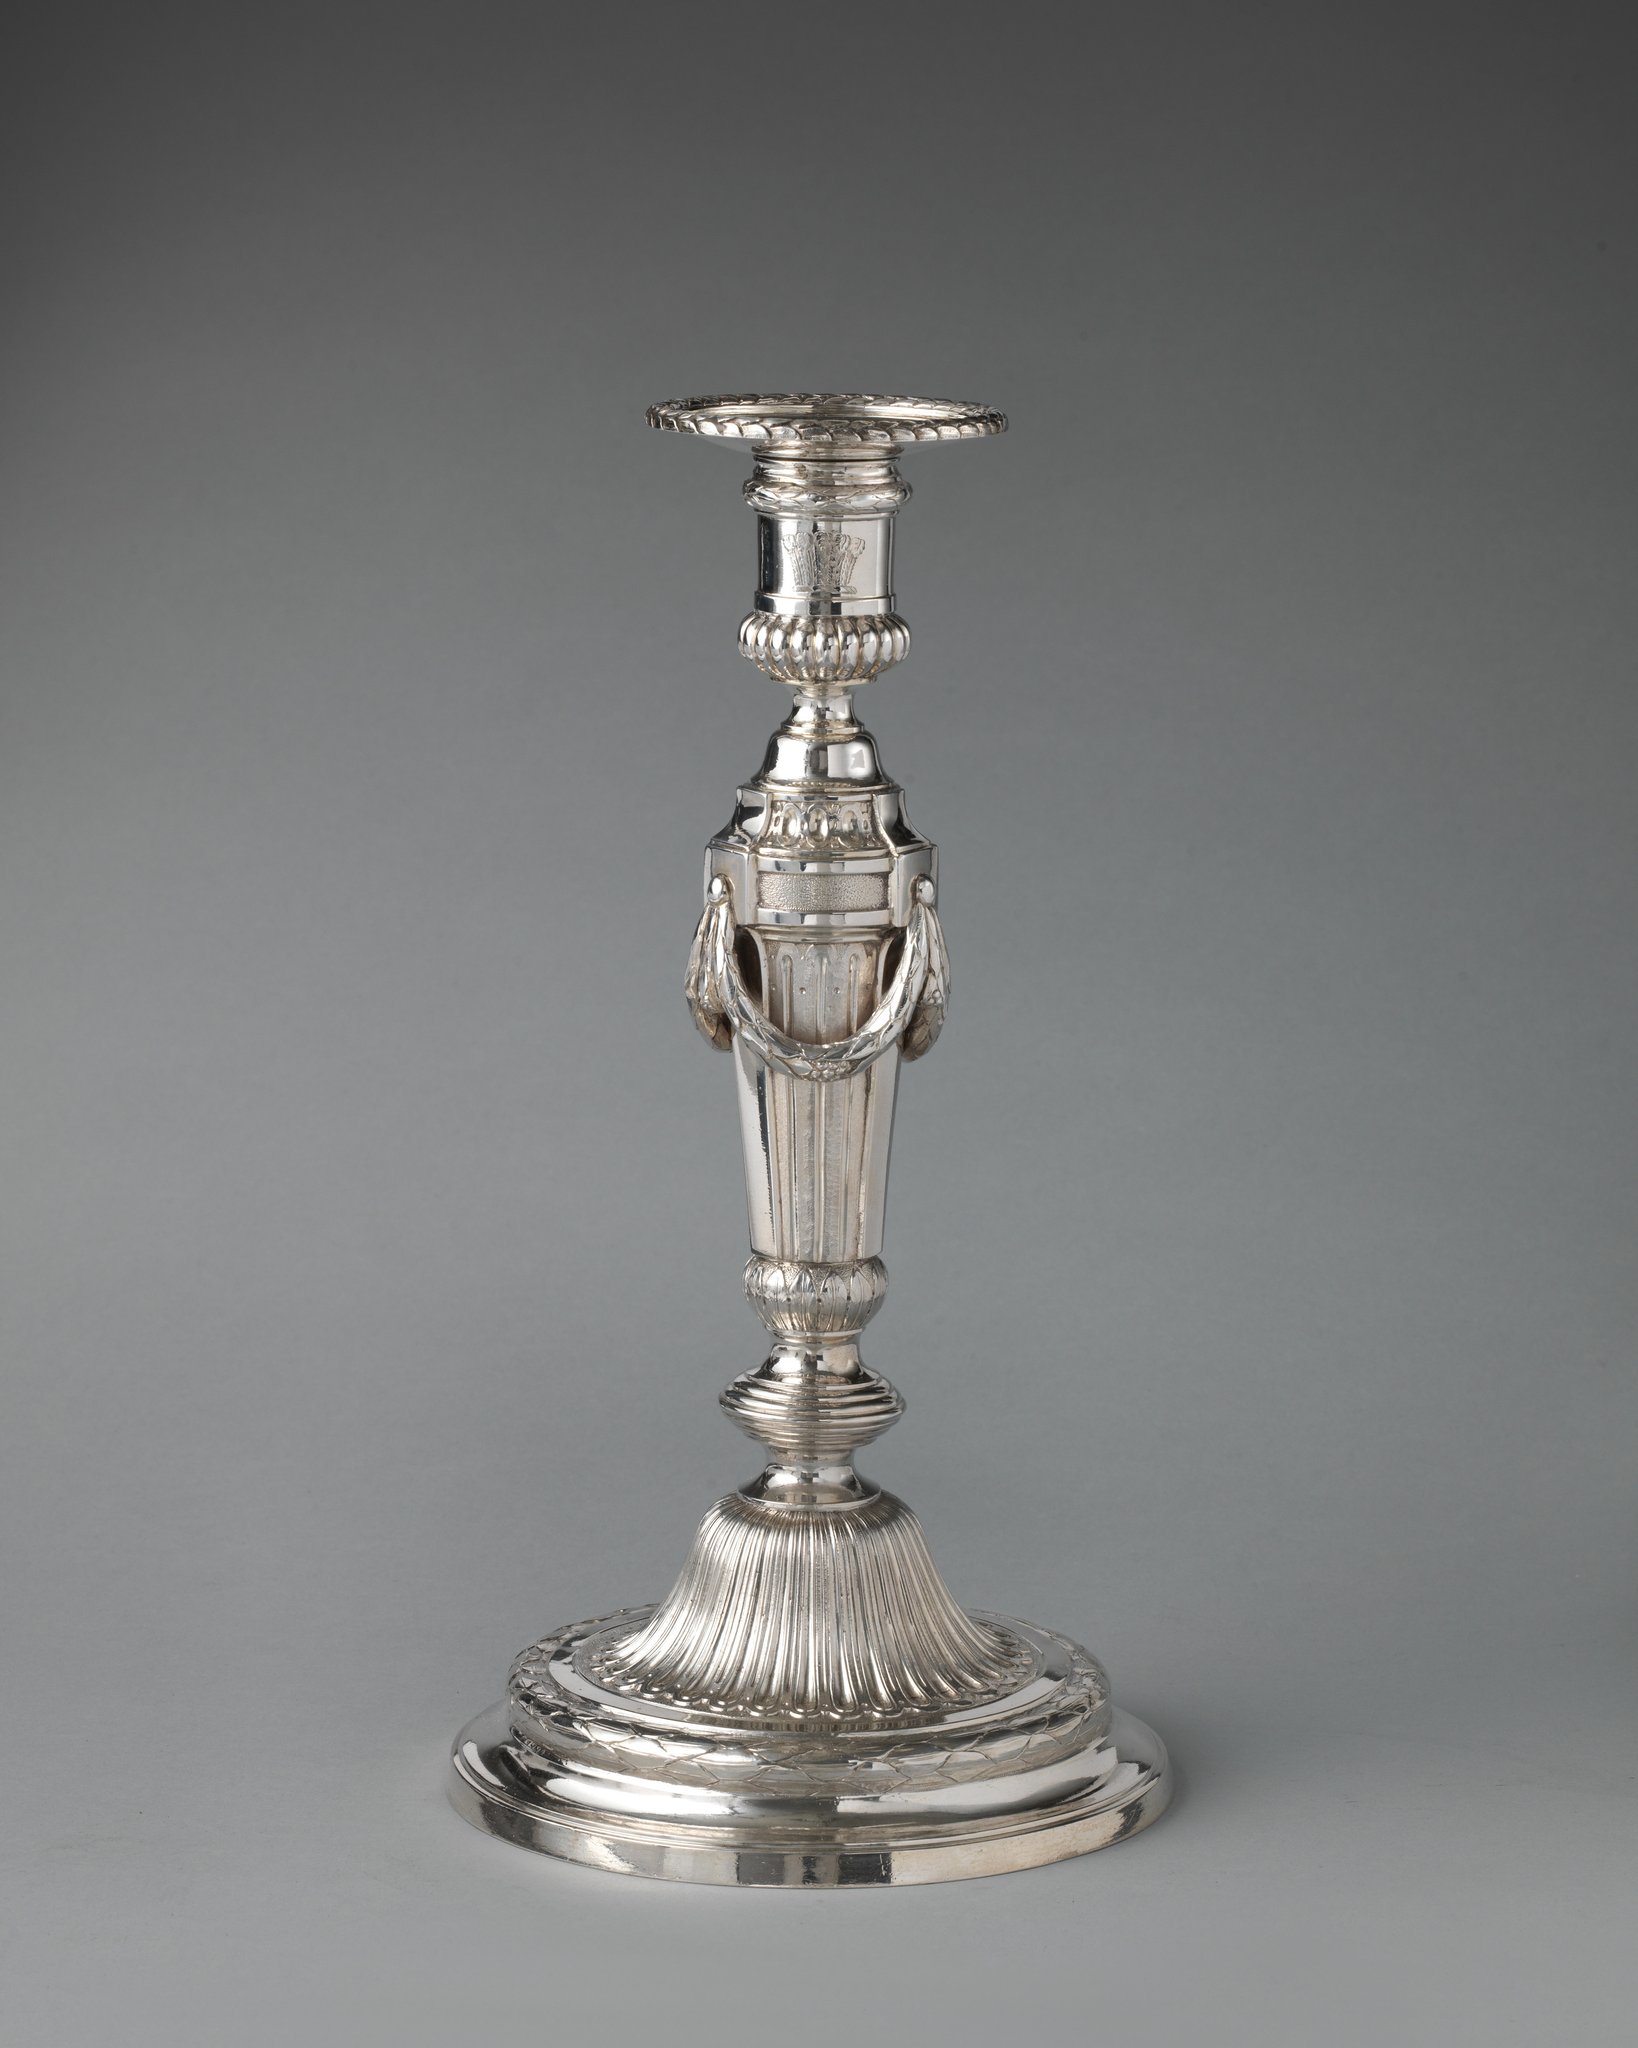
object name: candlestick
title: Candlestick (one of a set of eight)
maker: andrew fogelberg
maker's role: maker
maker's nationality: british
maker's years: 1750-1815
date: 1774-1775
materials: silver